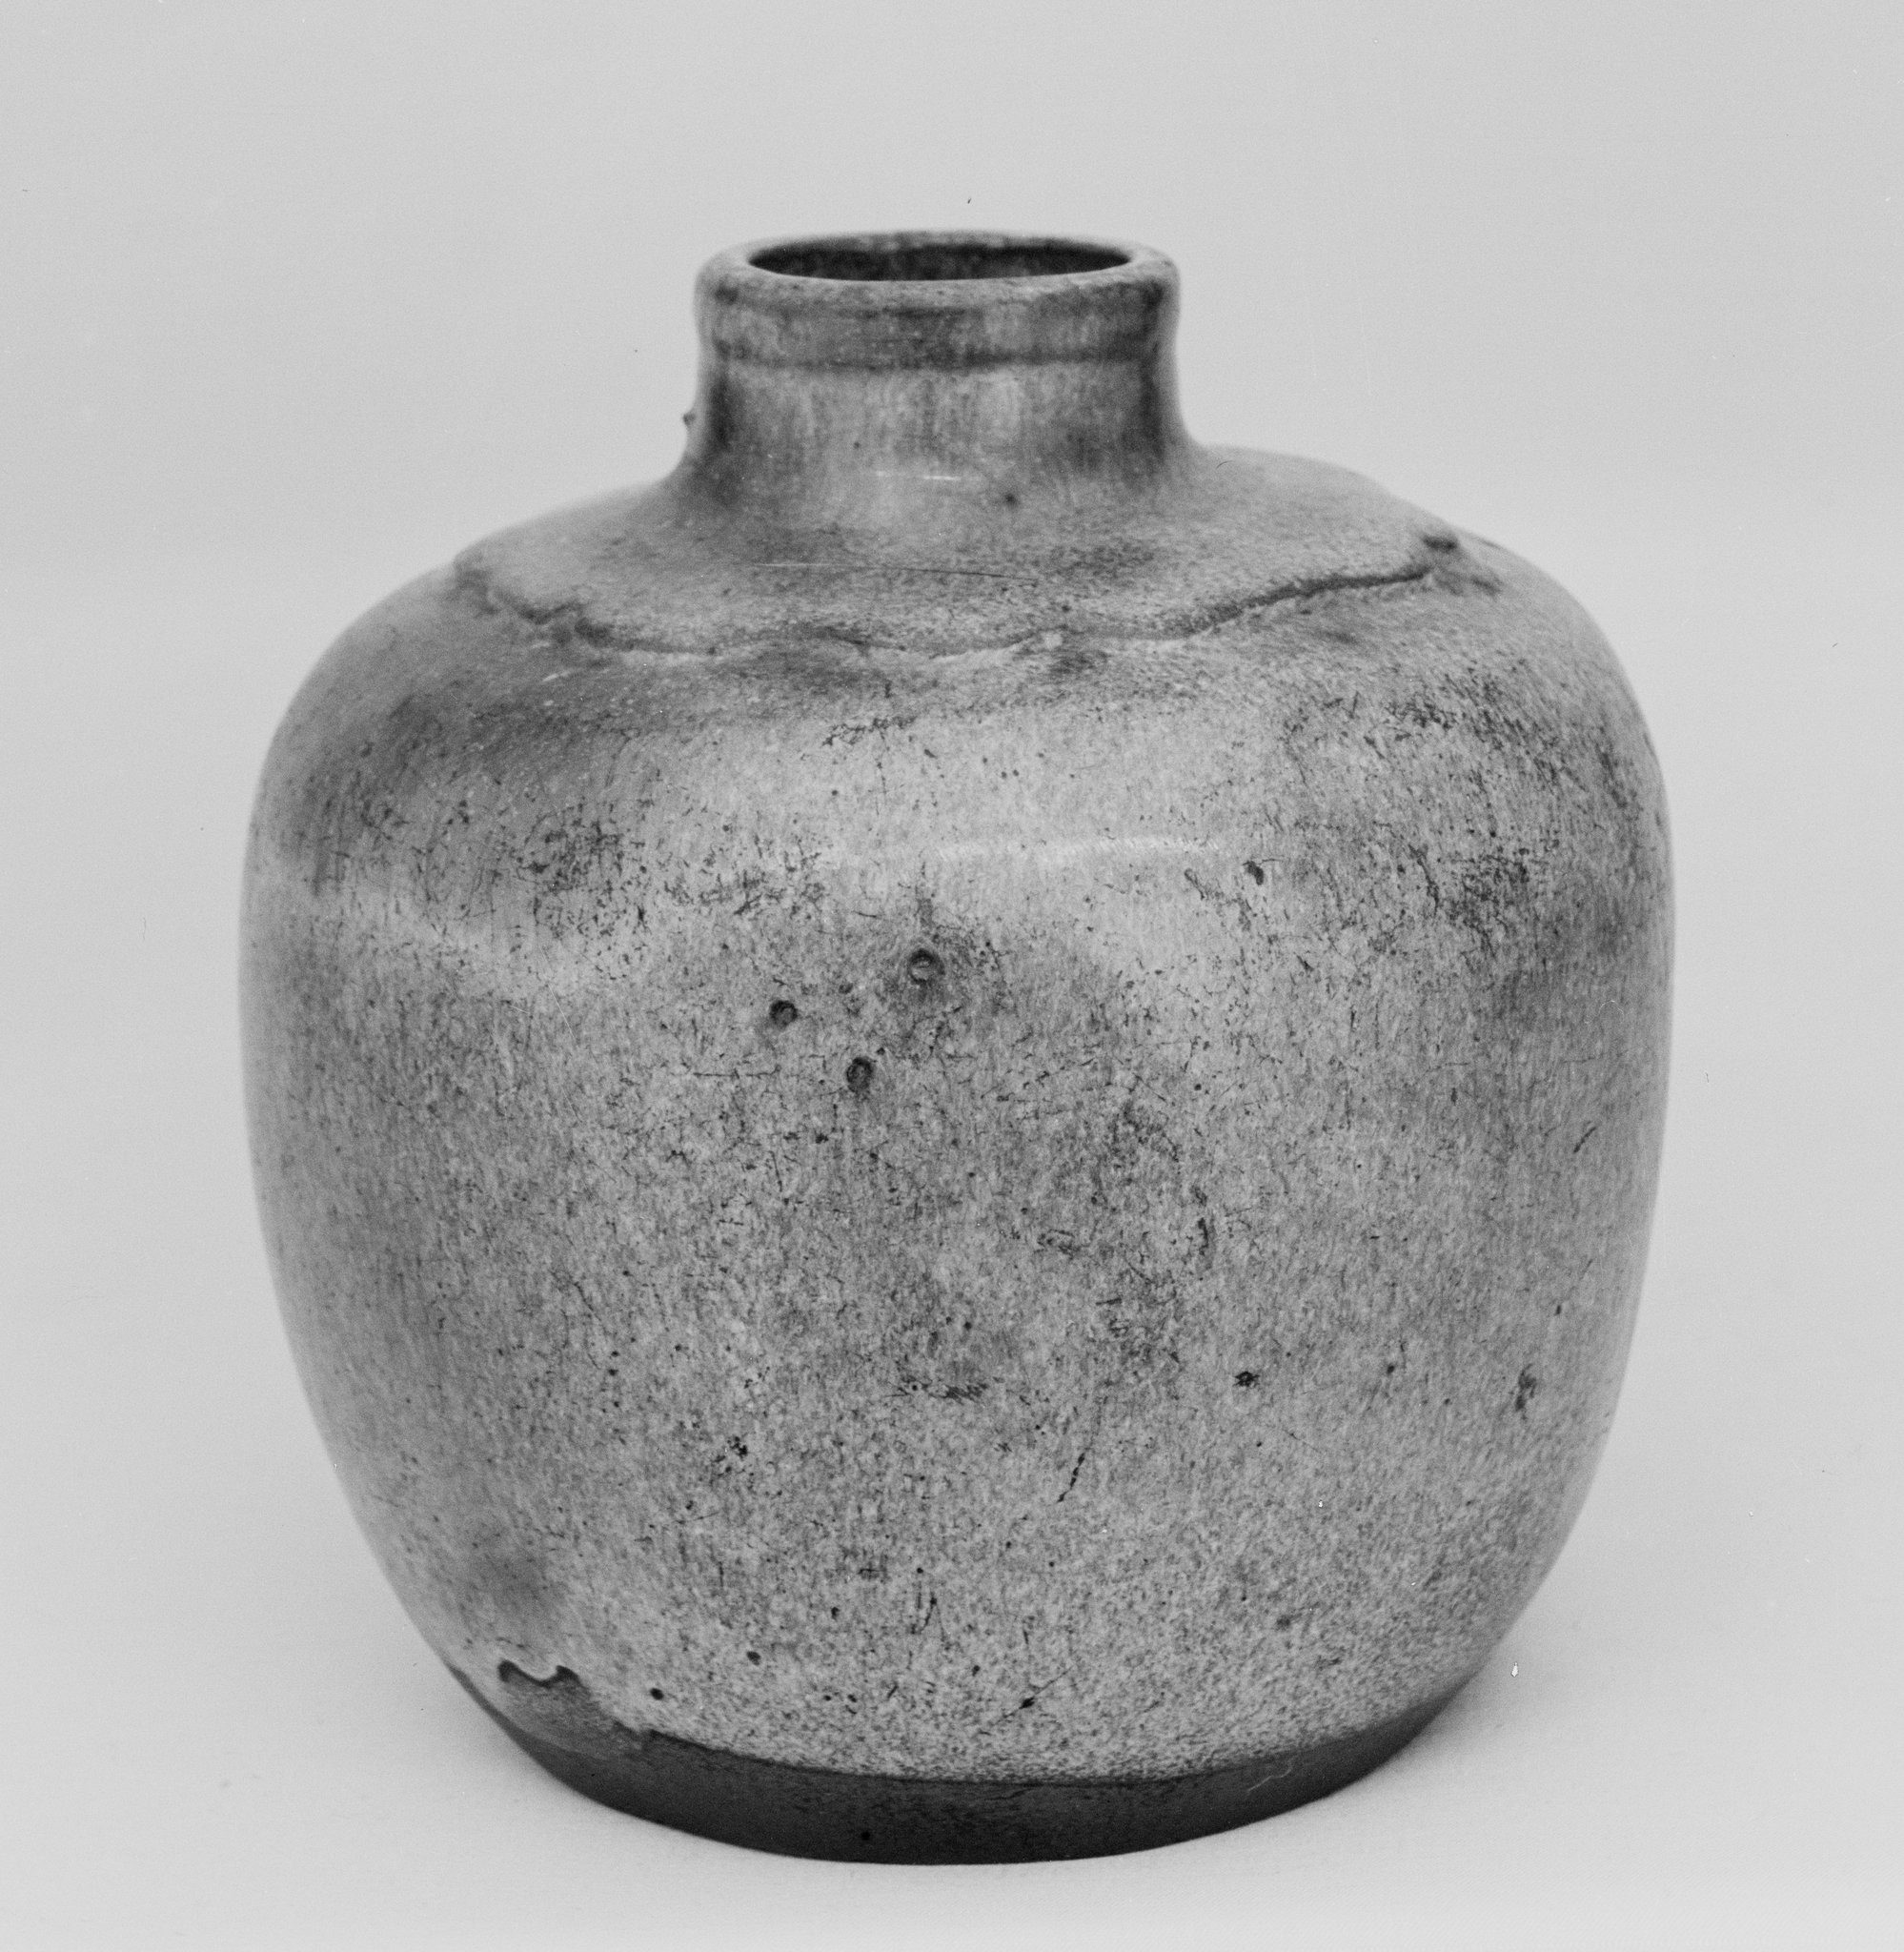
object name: bottle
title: Bottle for Sweets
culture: japanese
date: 1701-1800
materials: clay, glaze